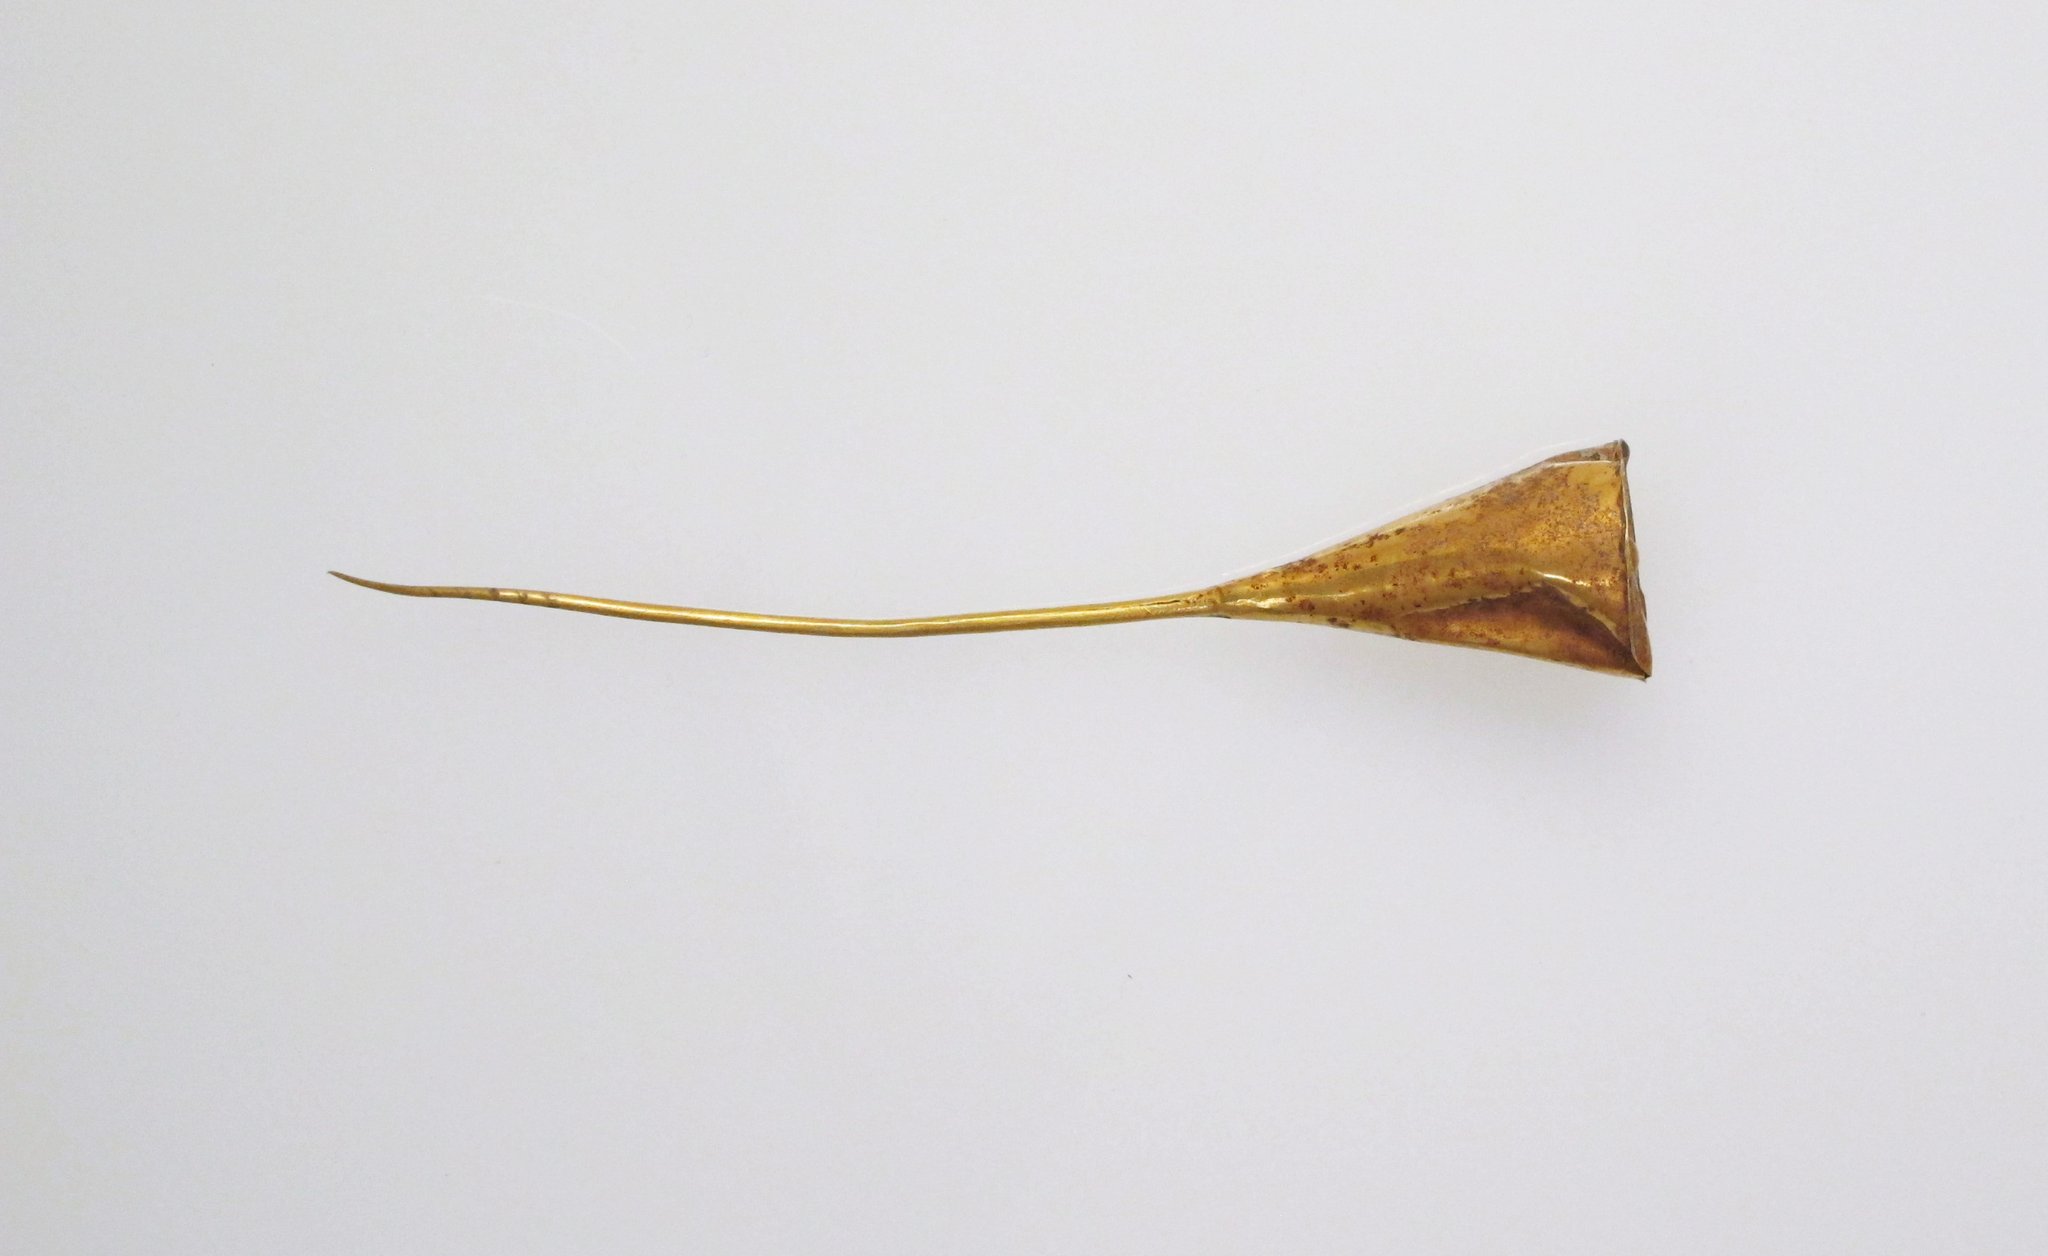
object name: rattle in the form of a poppy pod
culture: greek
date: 600-501 BCE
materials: gold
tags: musical instruments